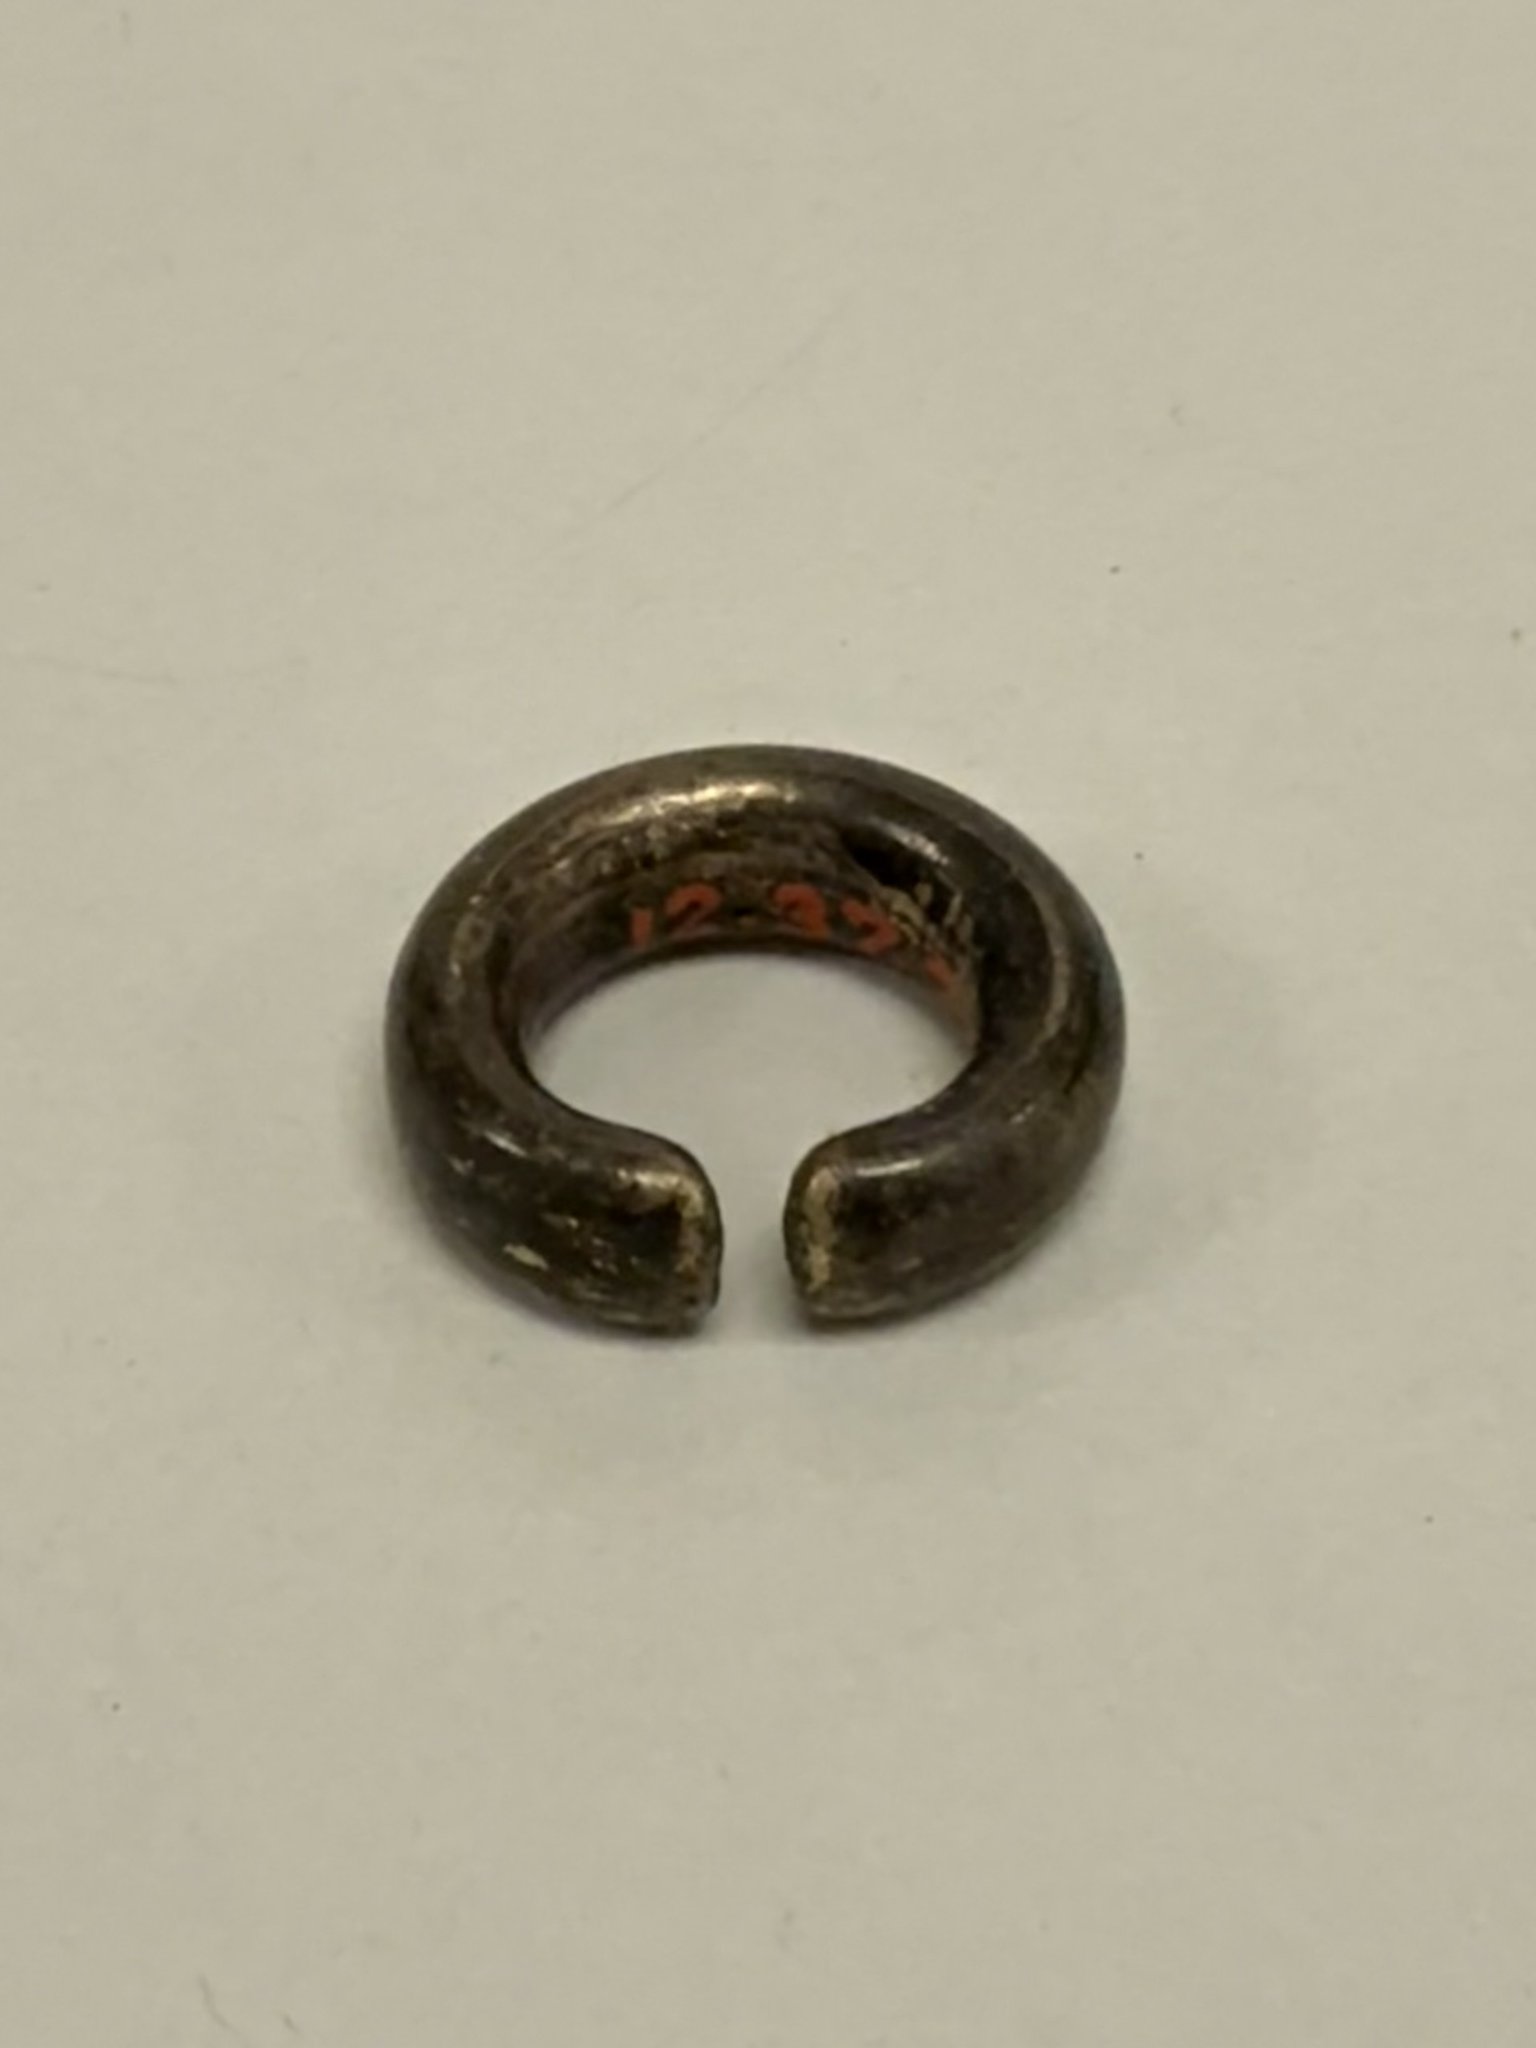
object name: earring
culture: japanese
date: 601-700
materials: metal